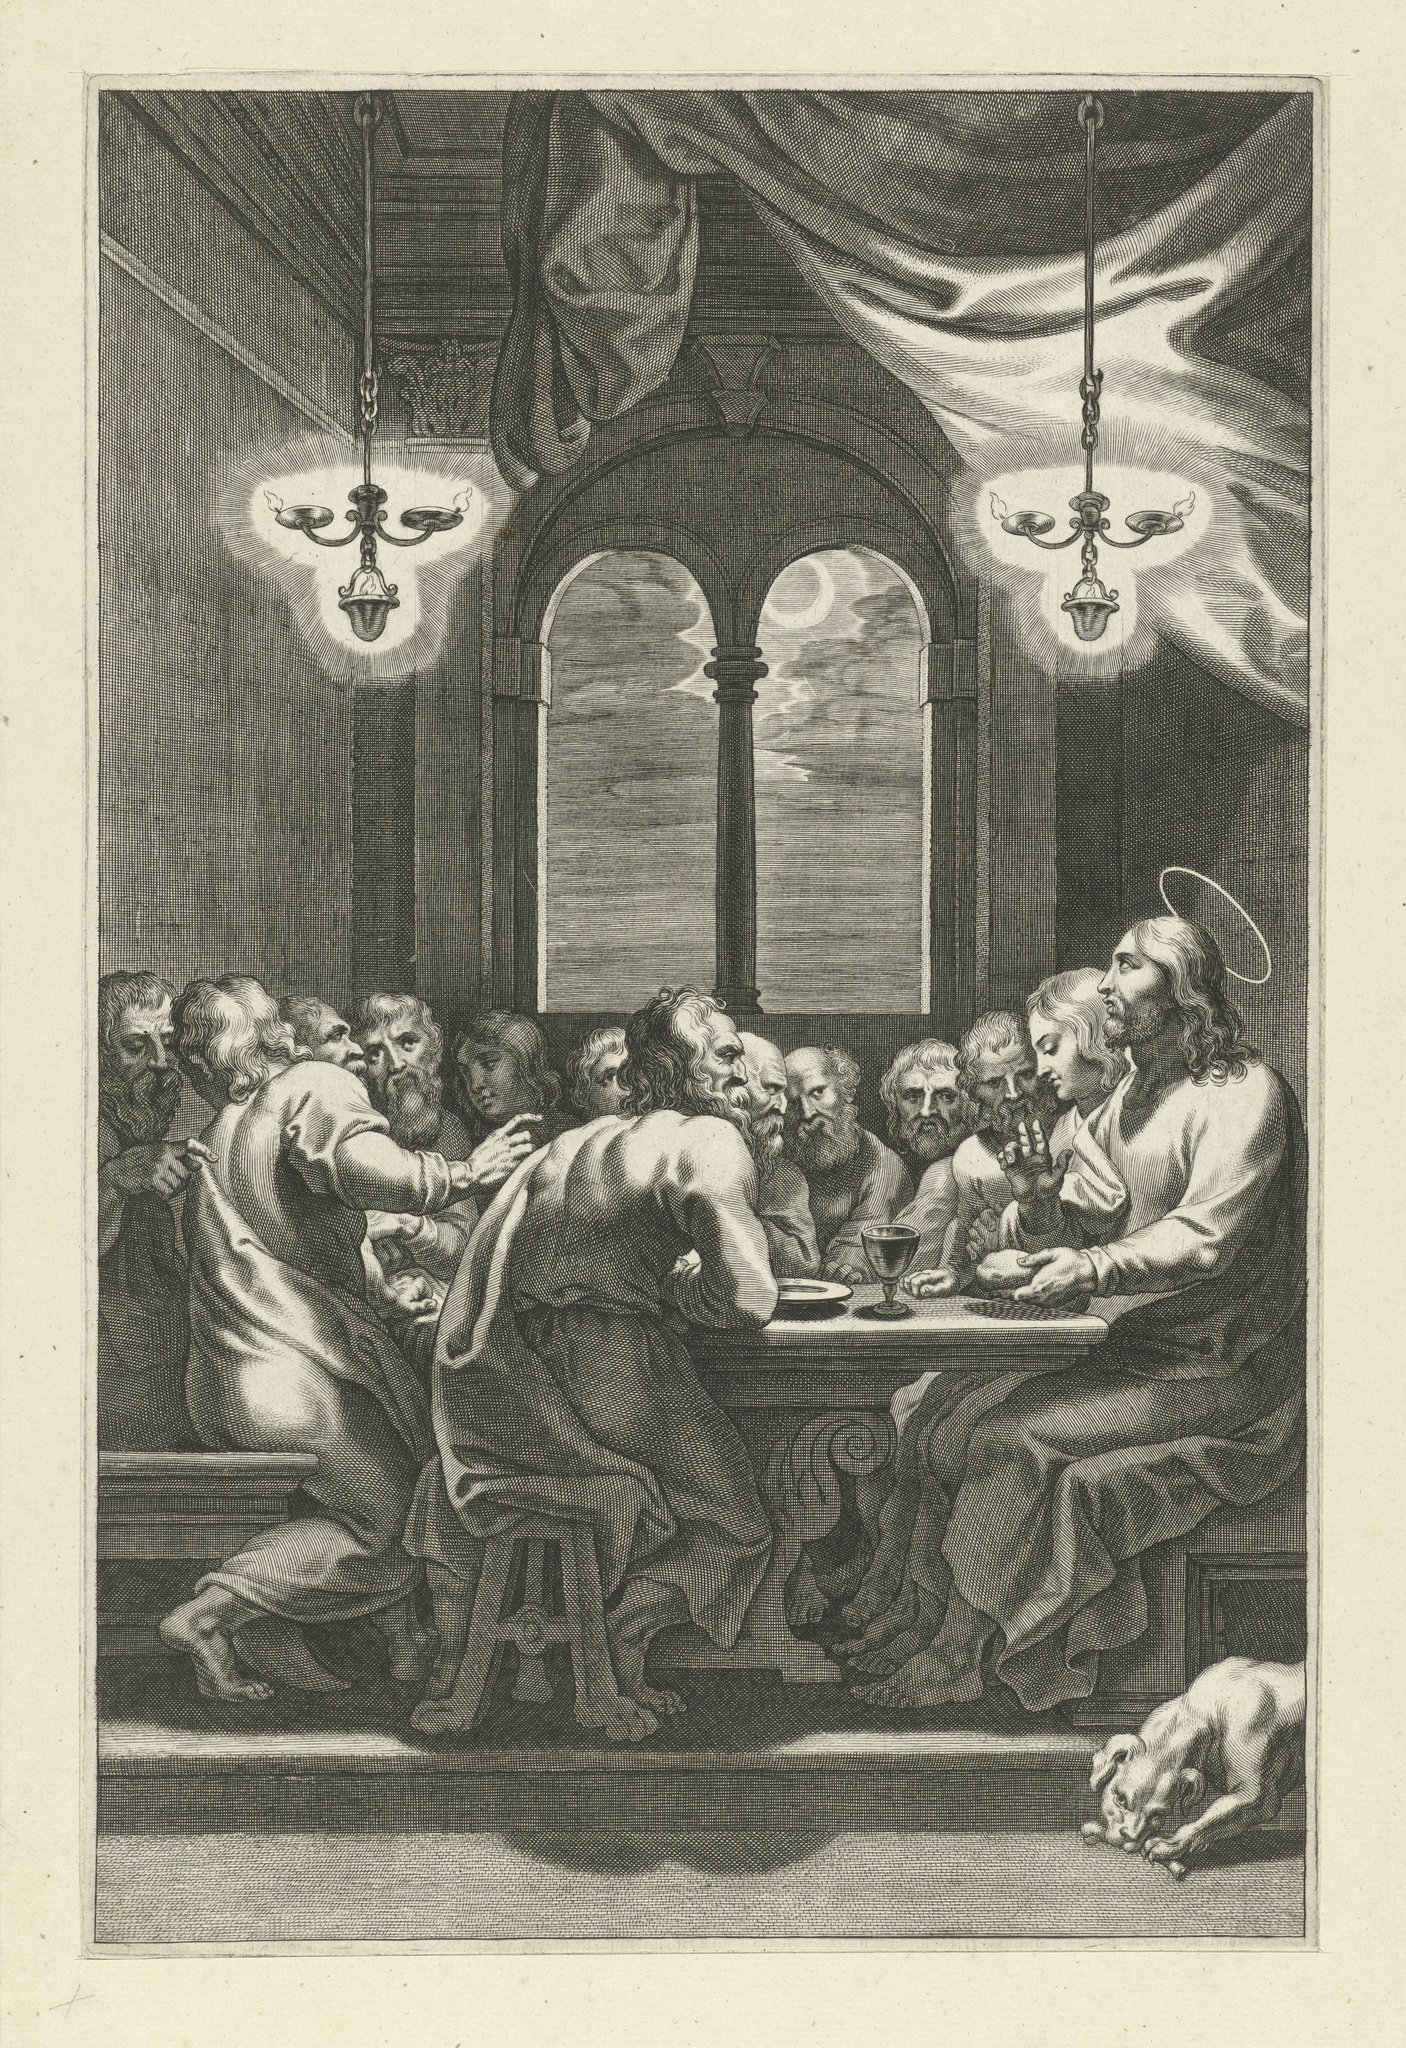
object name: print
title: Breviarium romanum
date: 1581-1633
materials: paper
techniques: engraving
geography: antwerp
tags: last supper (in general) (matthew 26:21-35; mark 14:18-31; luke 22:3, 22:15-23; john 13:21-38)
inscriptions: collector's mark: Lugt 240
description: Christus zit samen met zijn leerlingen aan een tafel. Hij deelt het brood uit. De prent is deel van een serie met scènes uit het Oude en Nieuwe Testament.